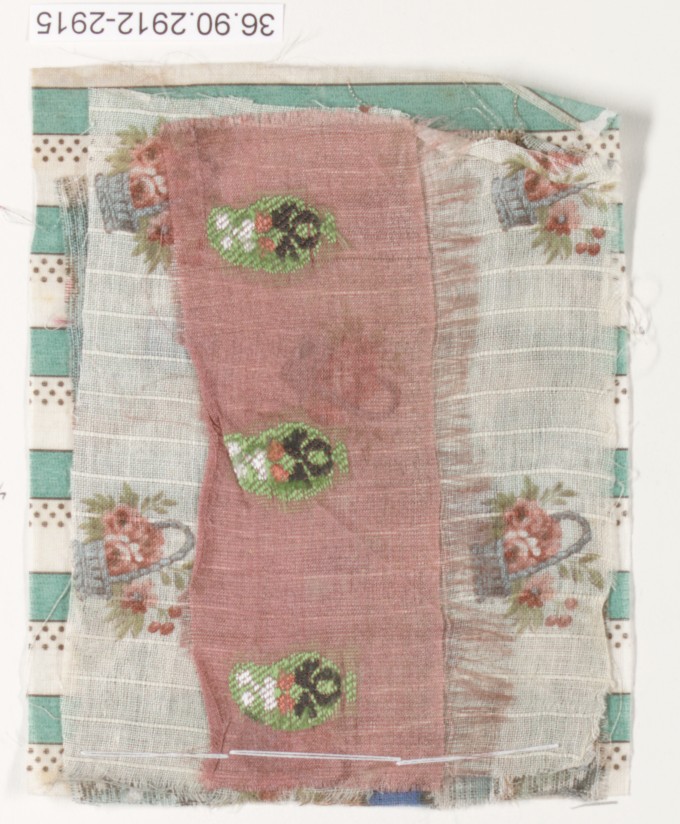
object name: piece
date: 1801-1900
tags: flowers